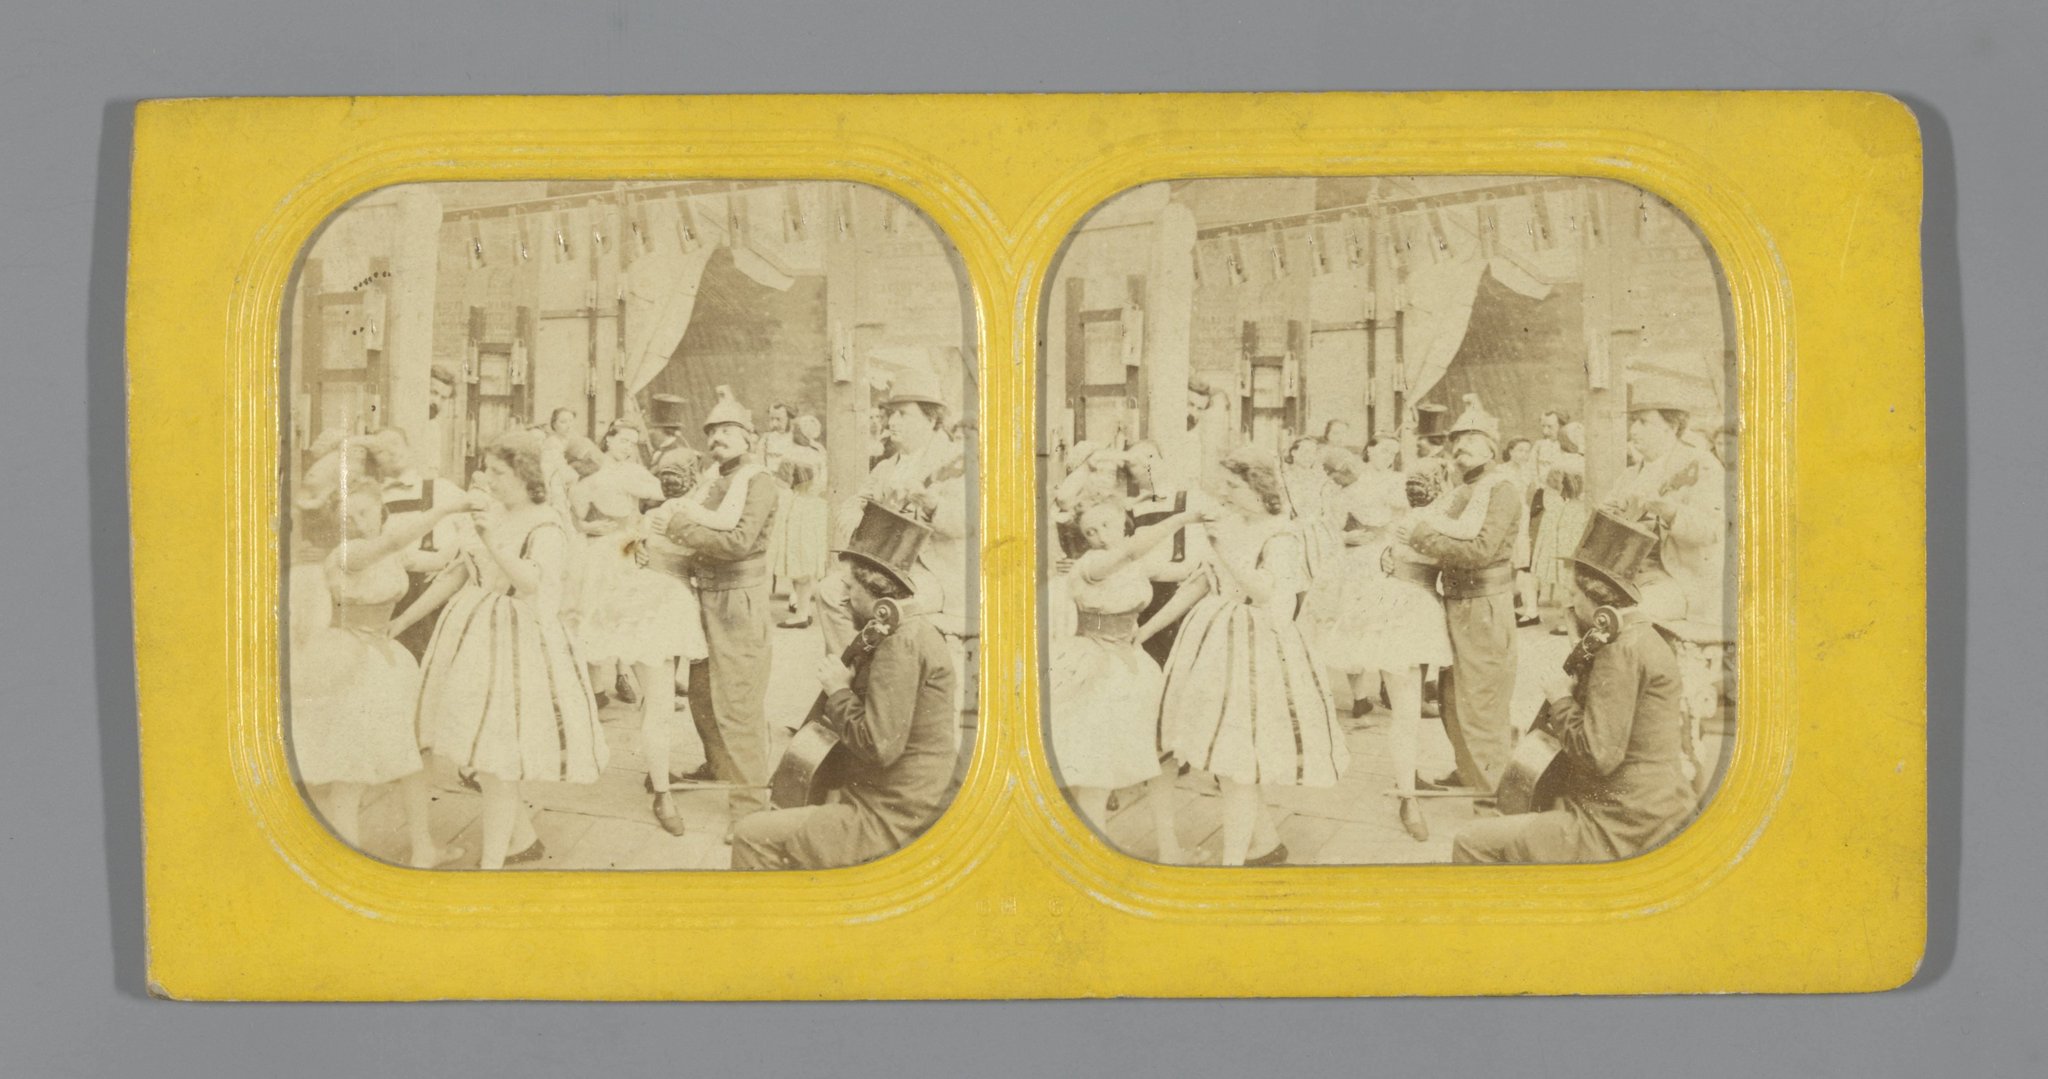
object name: tissue stereograph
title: Musici en dansende paren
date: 1855-1872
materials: cardboard, paper, photographic support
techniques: albumen print, cutting, hand coloring, perforating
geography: paris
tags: more than one couple dancing